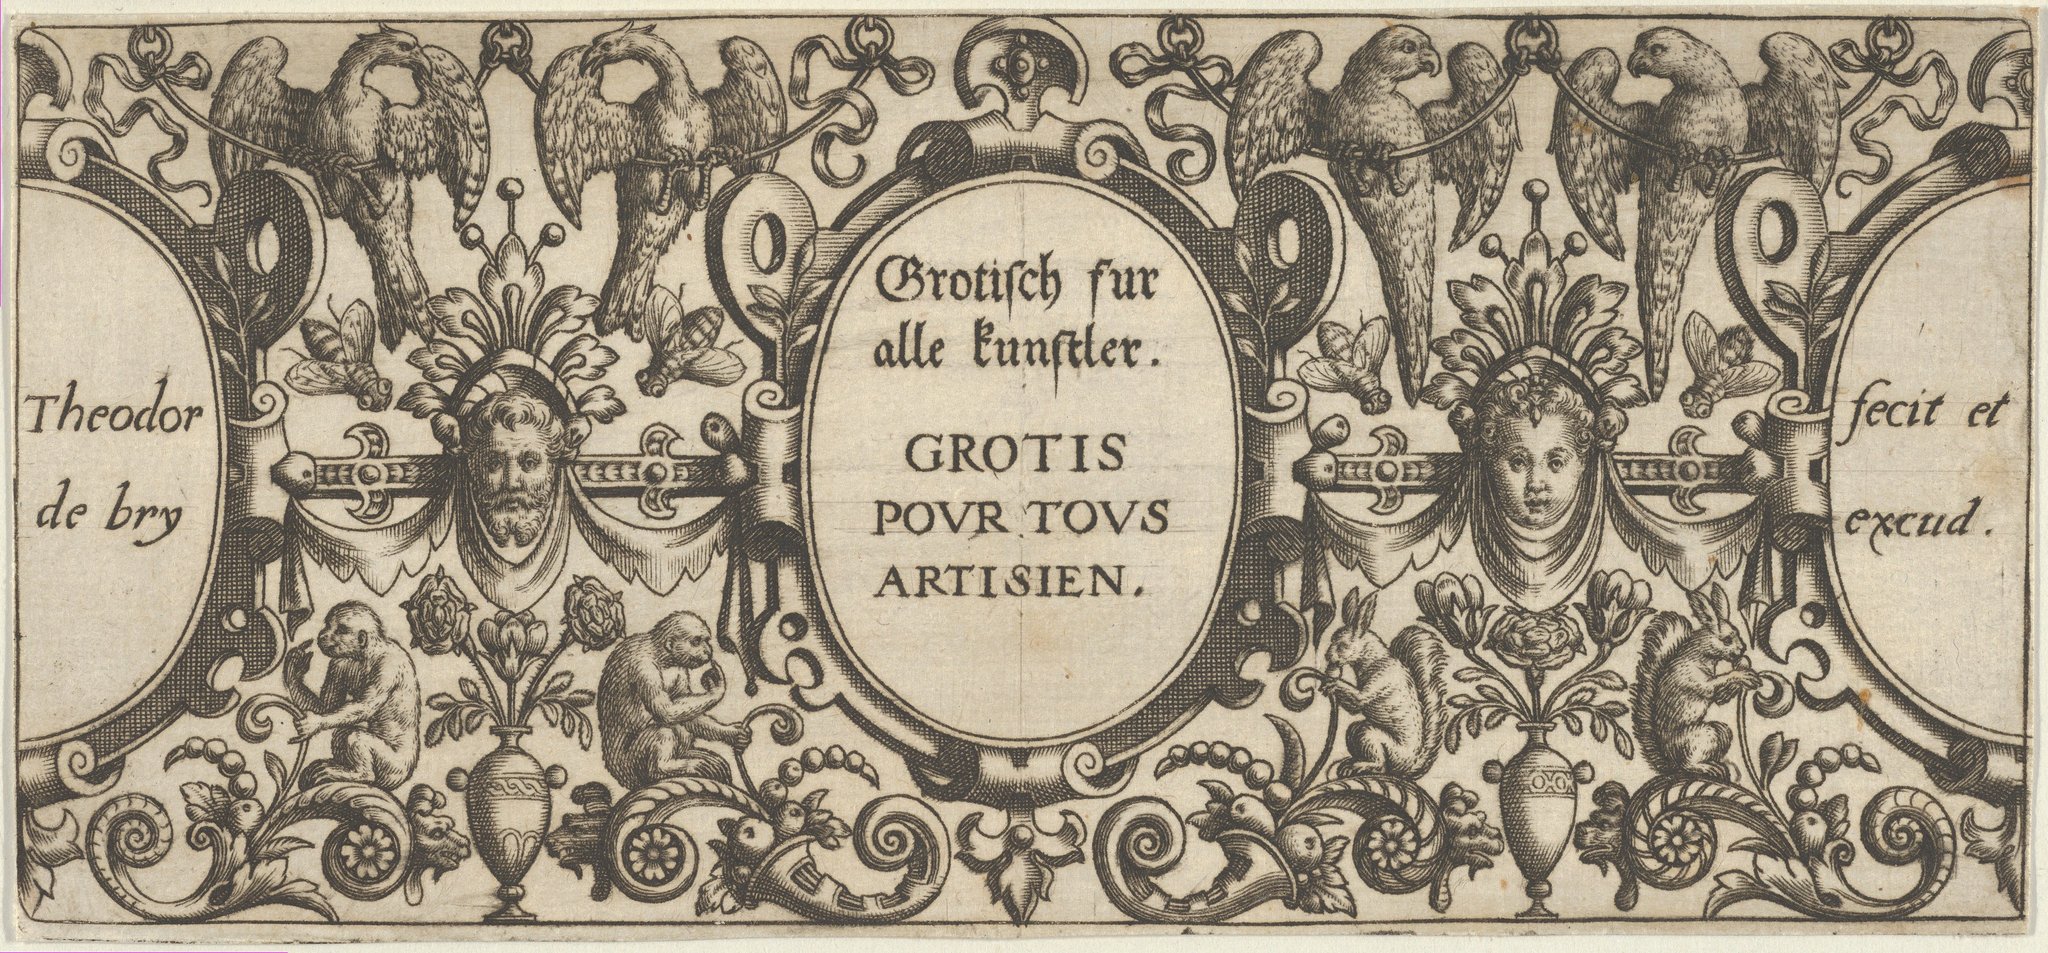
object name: print ornament architecture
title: Title Page, from Grotisch fur alle Kunstler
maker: theodor de bry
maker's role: artist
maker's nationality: netherlandish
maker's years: 1528-1598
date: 1580-1600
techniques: engraving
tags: birds,cartouches,children,men